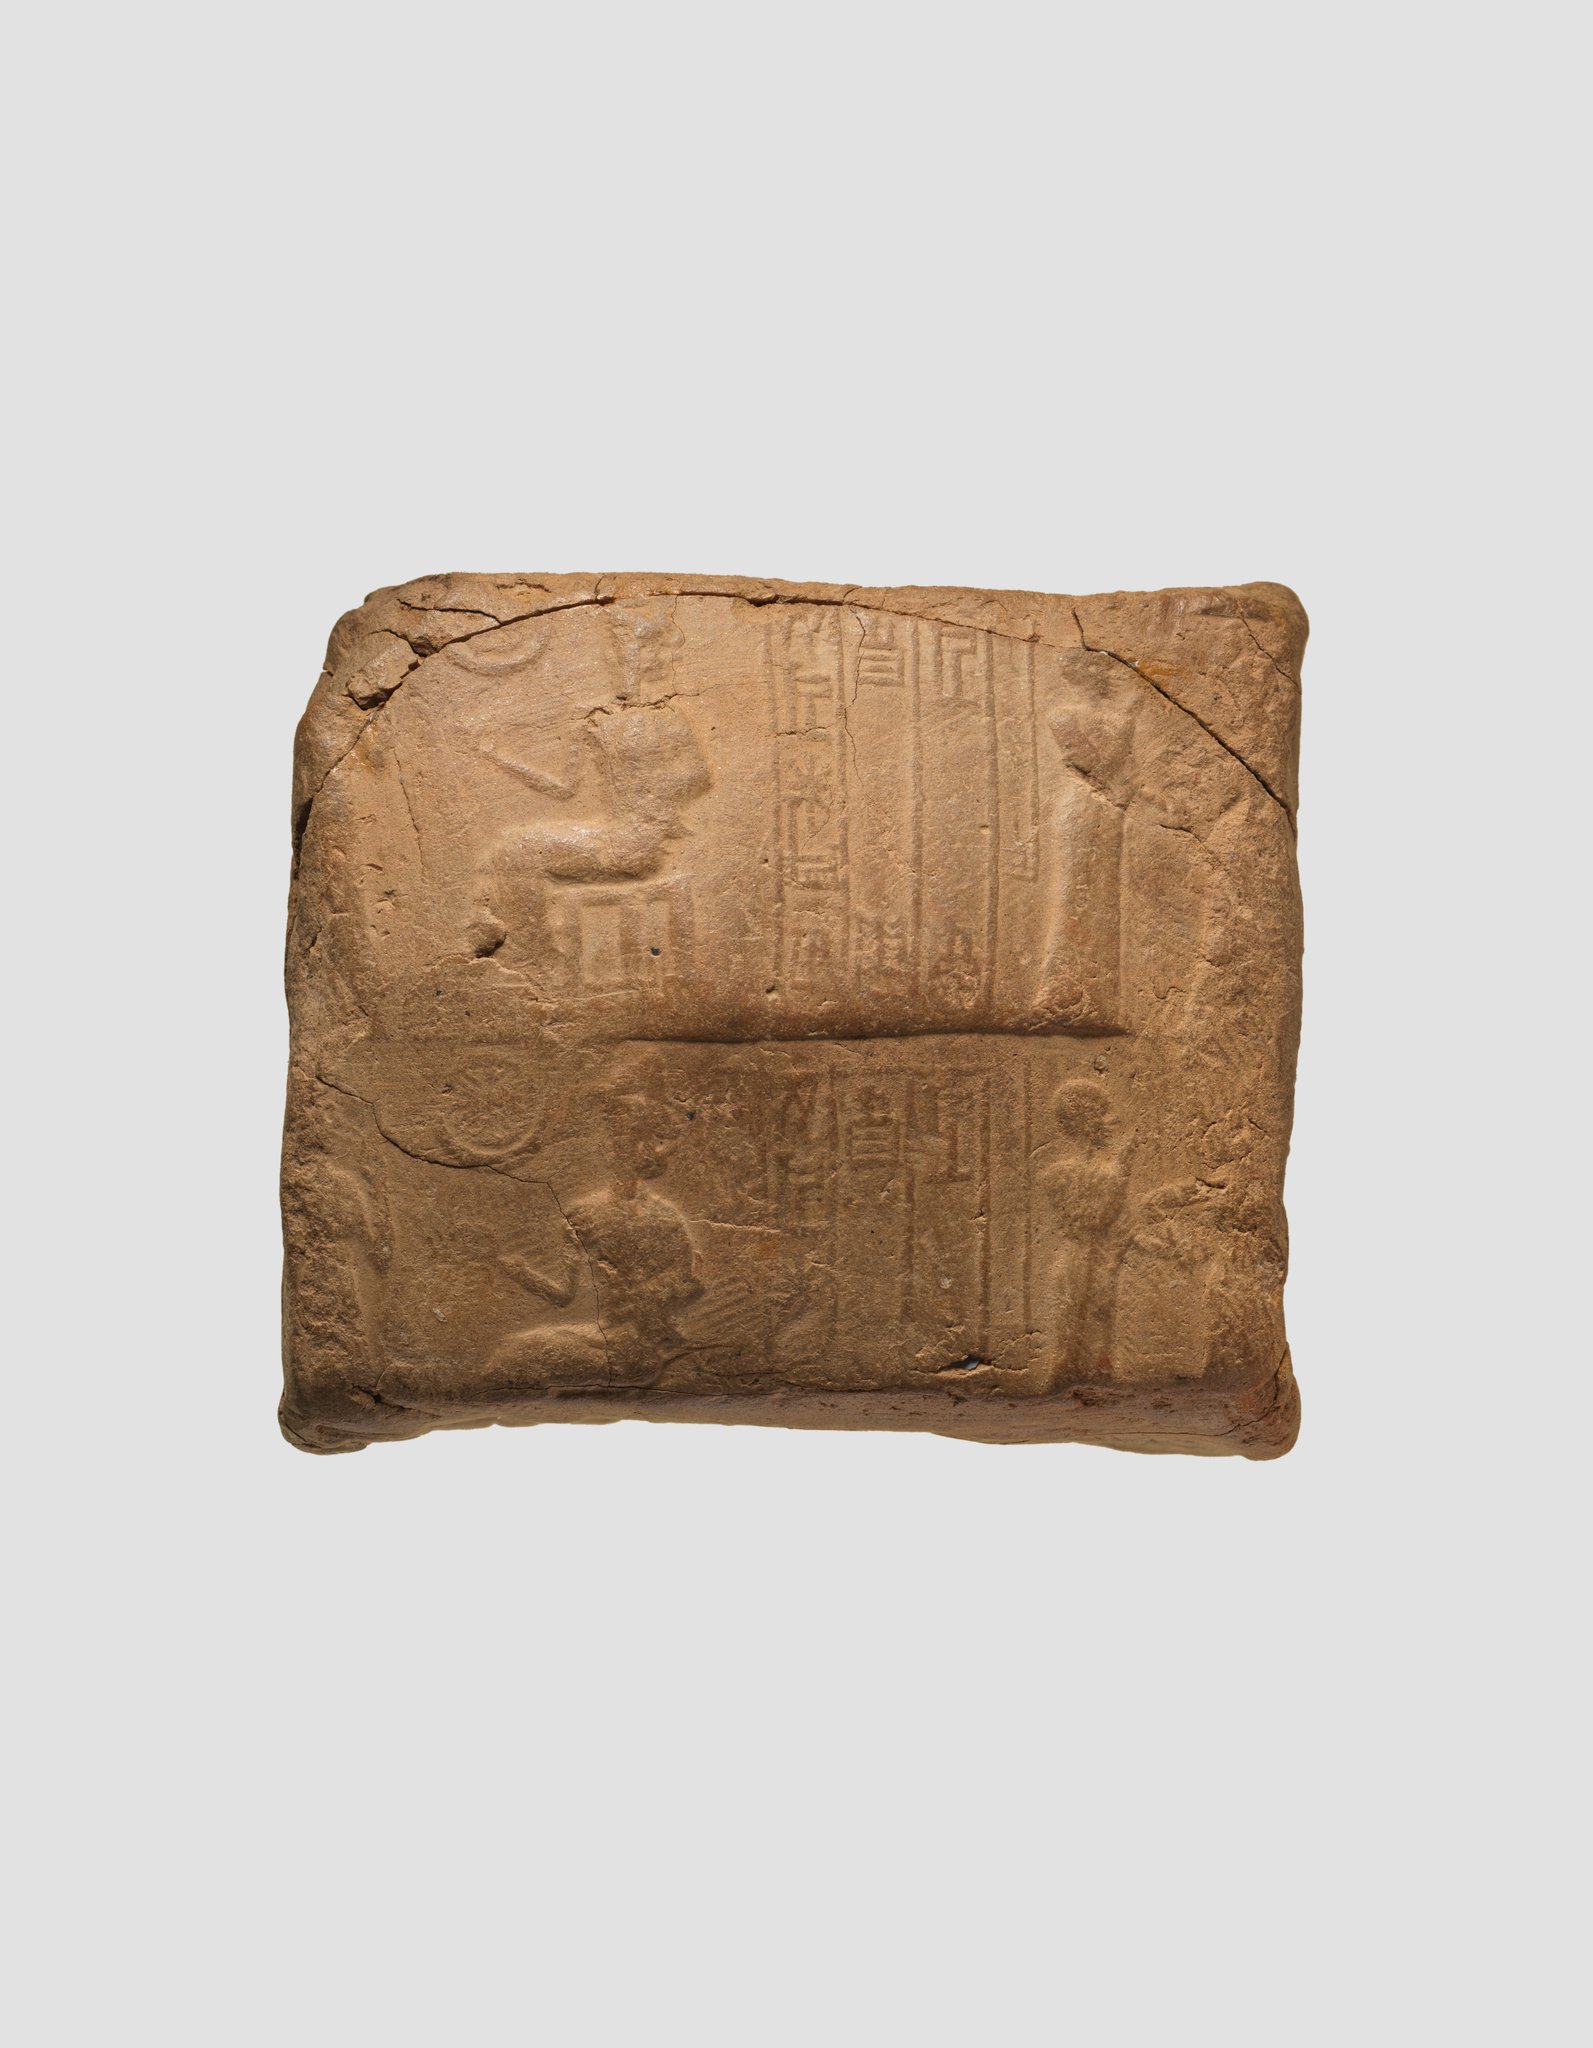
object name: cuneiform tablet case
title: Cuneiform tablet case impressed with cylinder seal, for cuneiform tablet 86.11.248a: receipt of straw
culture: neo-sumerian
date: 2040 BCE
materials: clay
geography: mesopotamia